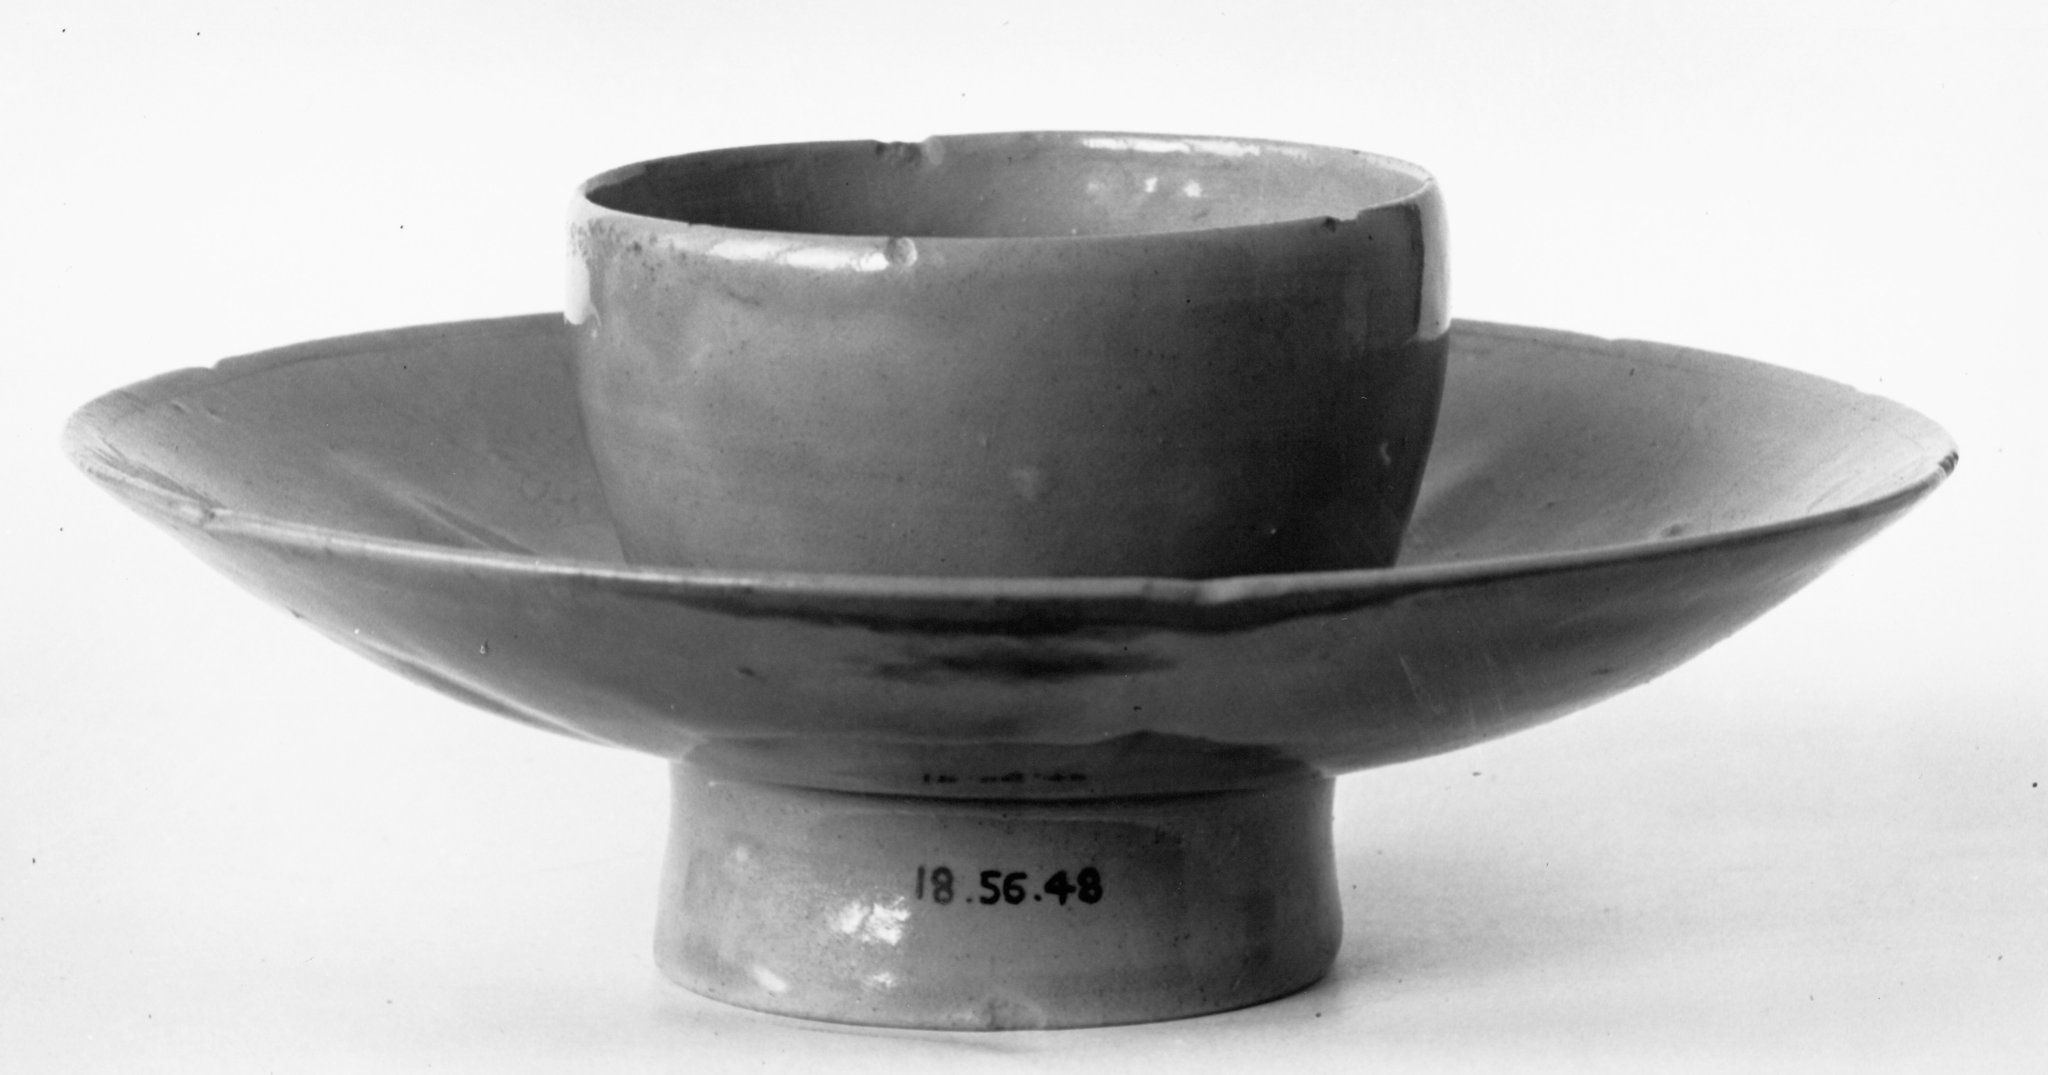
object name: cup stand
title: Cup and Stand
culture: chinese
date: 960-1279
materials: pottery